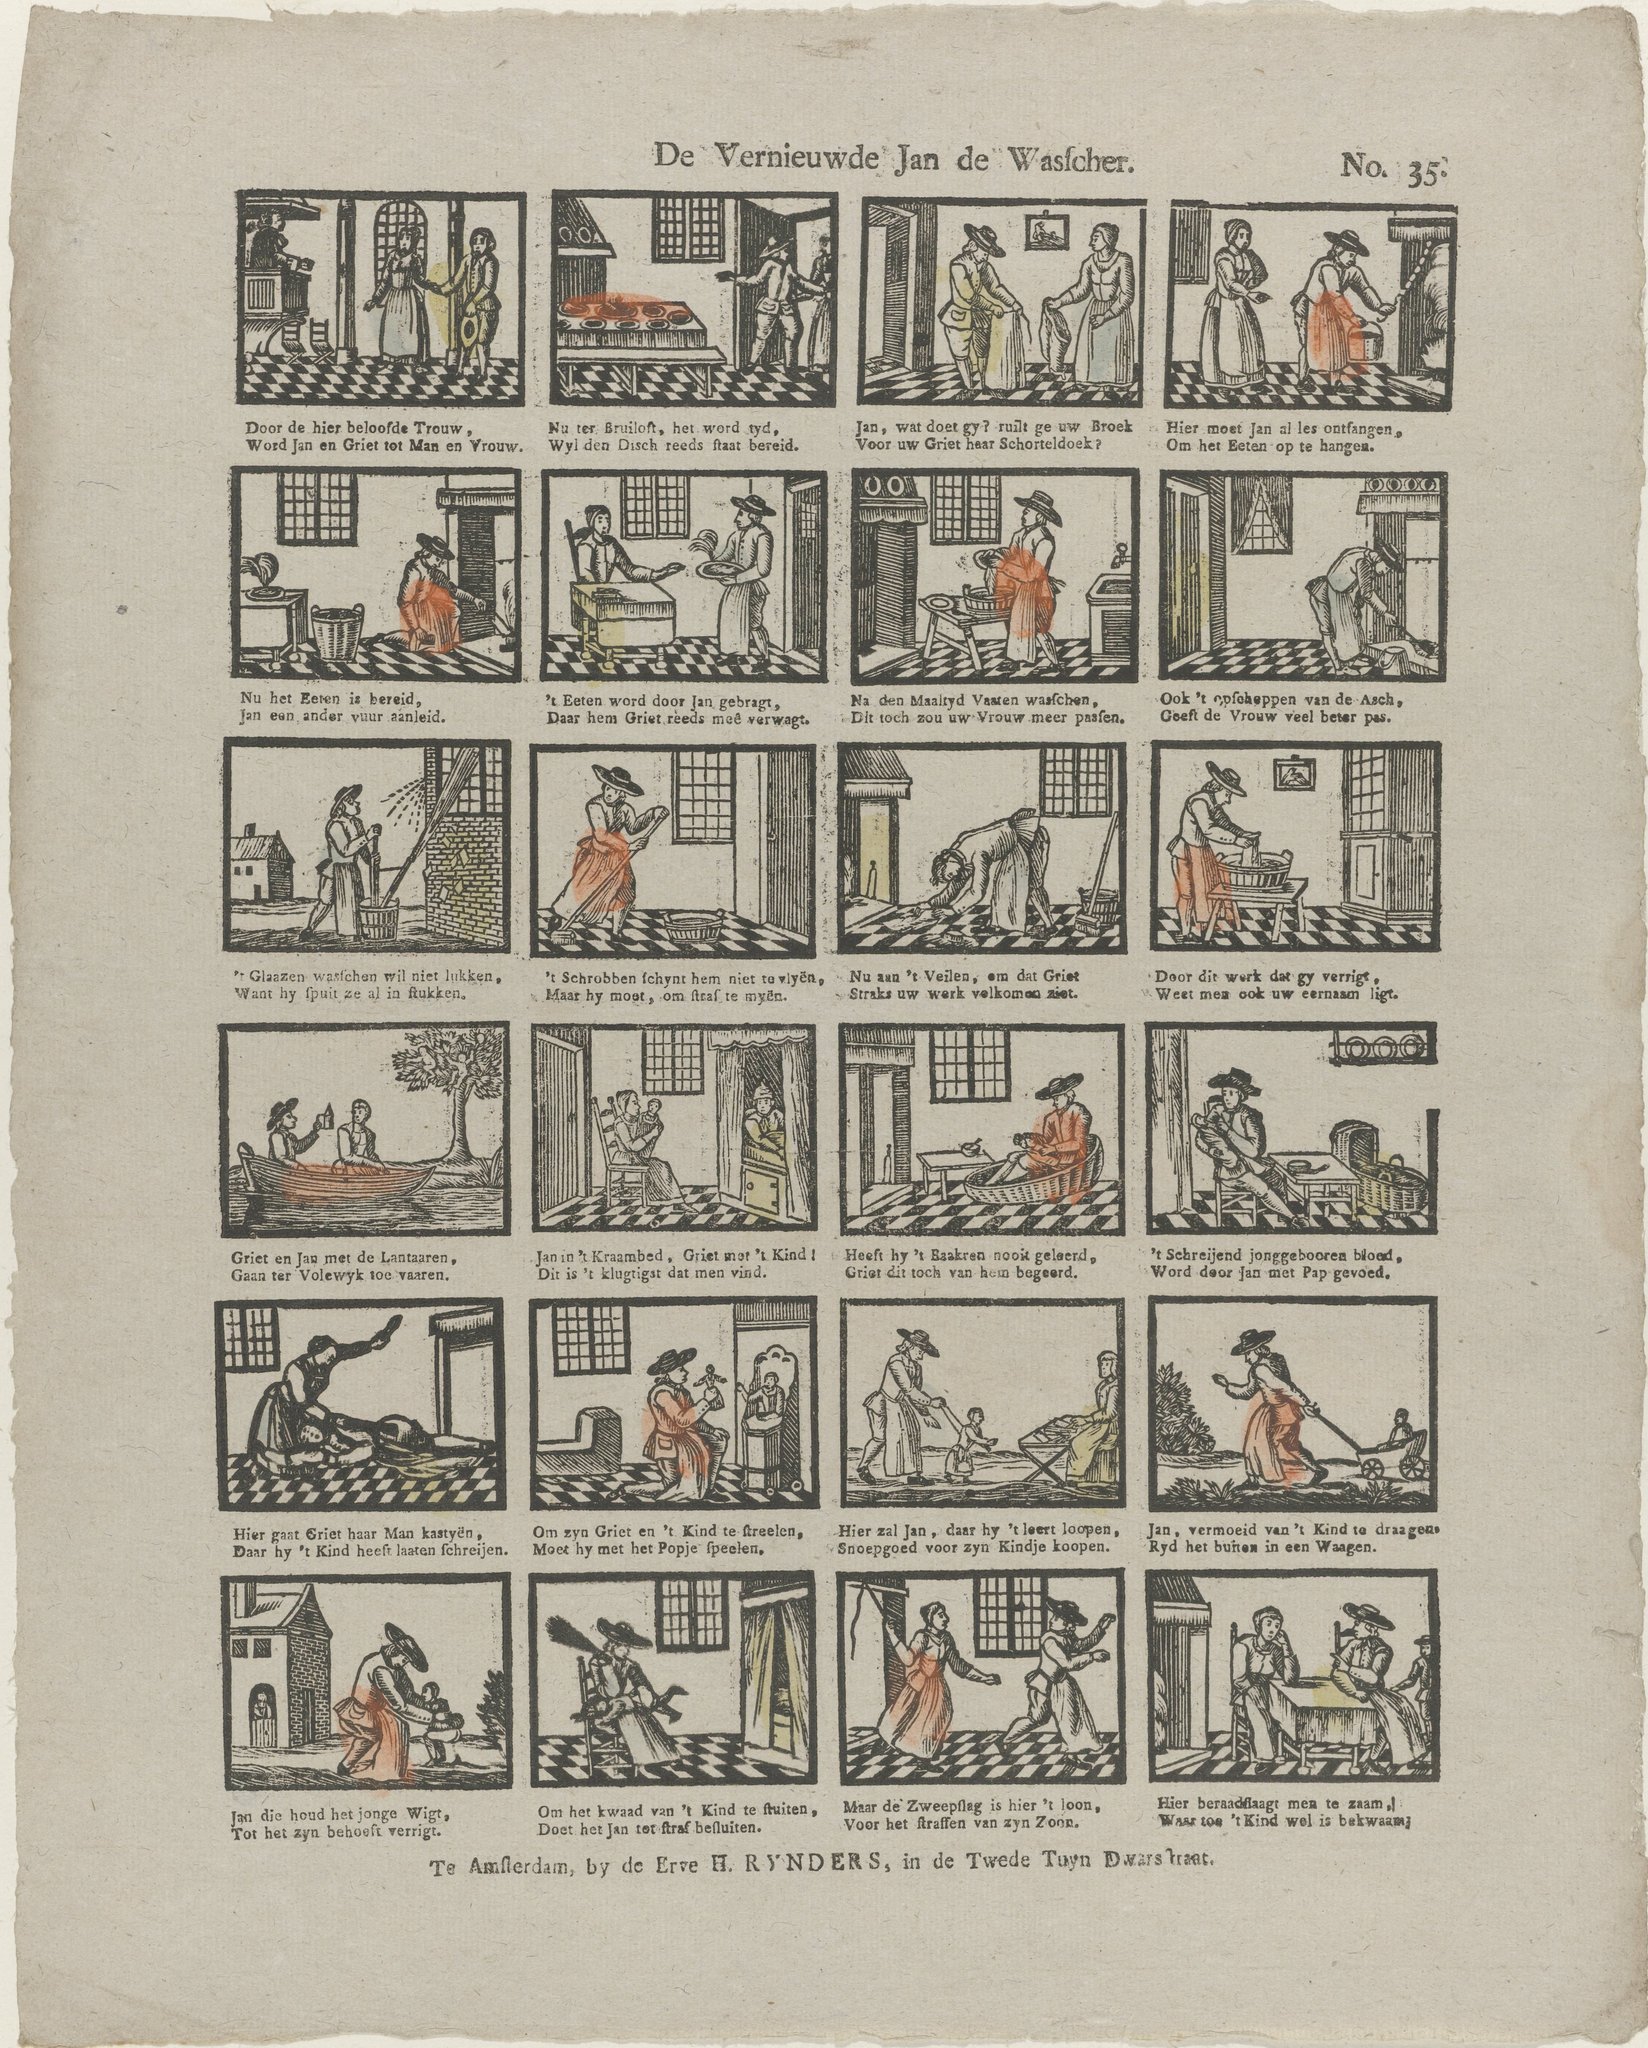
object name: print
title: De vernieuwde Jan de Wasscher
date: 1831-1854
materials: paper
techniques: colour, letterpress printing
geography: amsterdam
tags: hen-pecked husband, 'betty', 'molly' (man who engages in women's work)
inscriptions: collector's mark: Lugt 2760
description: Blad met 24 voorstellingen over het leven van Jan de Wasser, een man die van zijn vrouw Griet, die de broek aan heeft, al het huishoudelijk werk moet doen. Onder elke afbeelding een tweeregelig vers. Genummerd rechtsboven: No. 35.